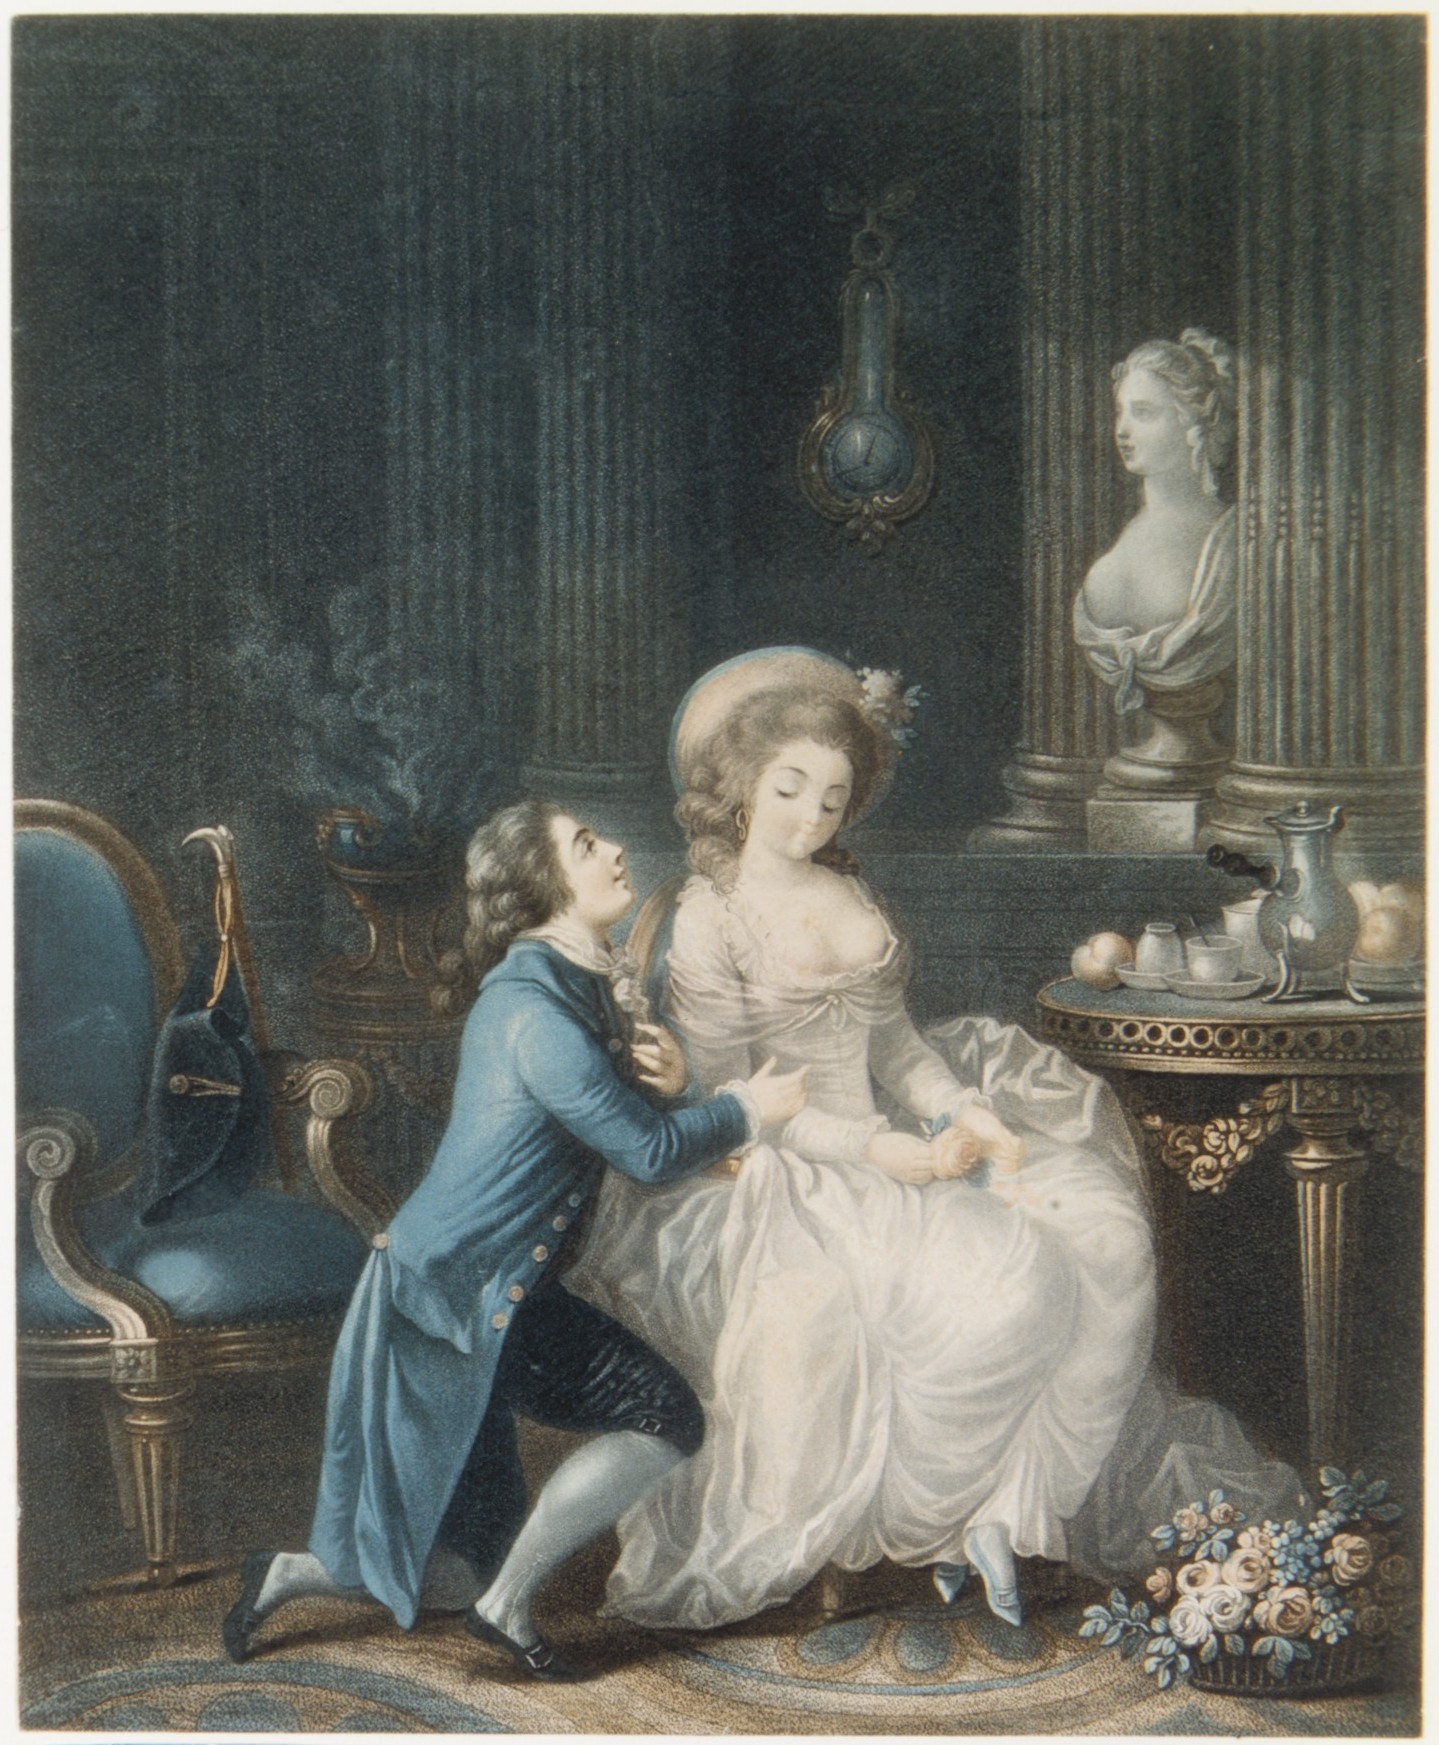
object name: print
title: The Lover Heard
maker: louis marin bonnet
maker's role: artist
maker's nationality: french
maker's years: 1736-1793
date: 1785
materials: ink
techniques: printing, stippling, wash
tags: sculpture,men,lovers,women